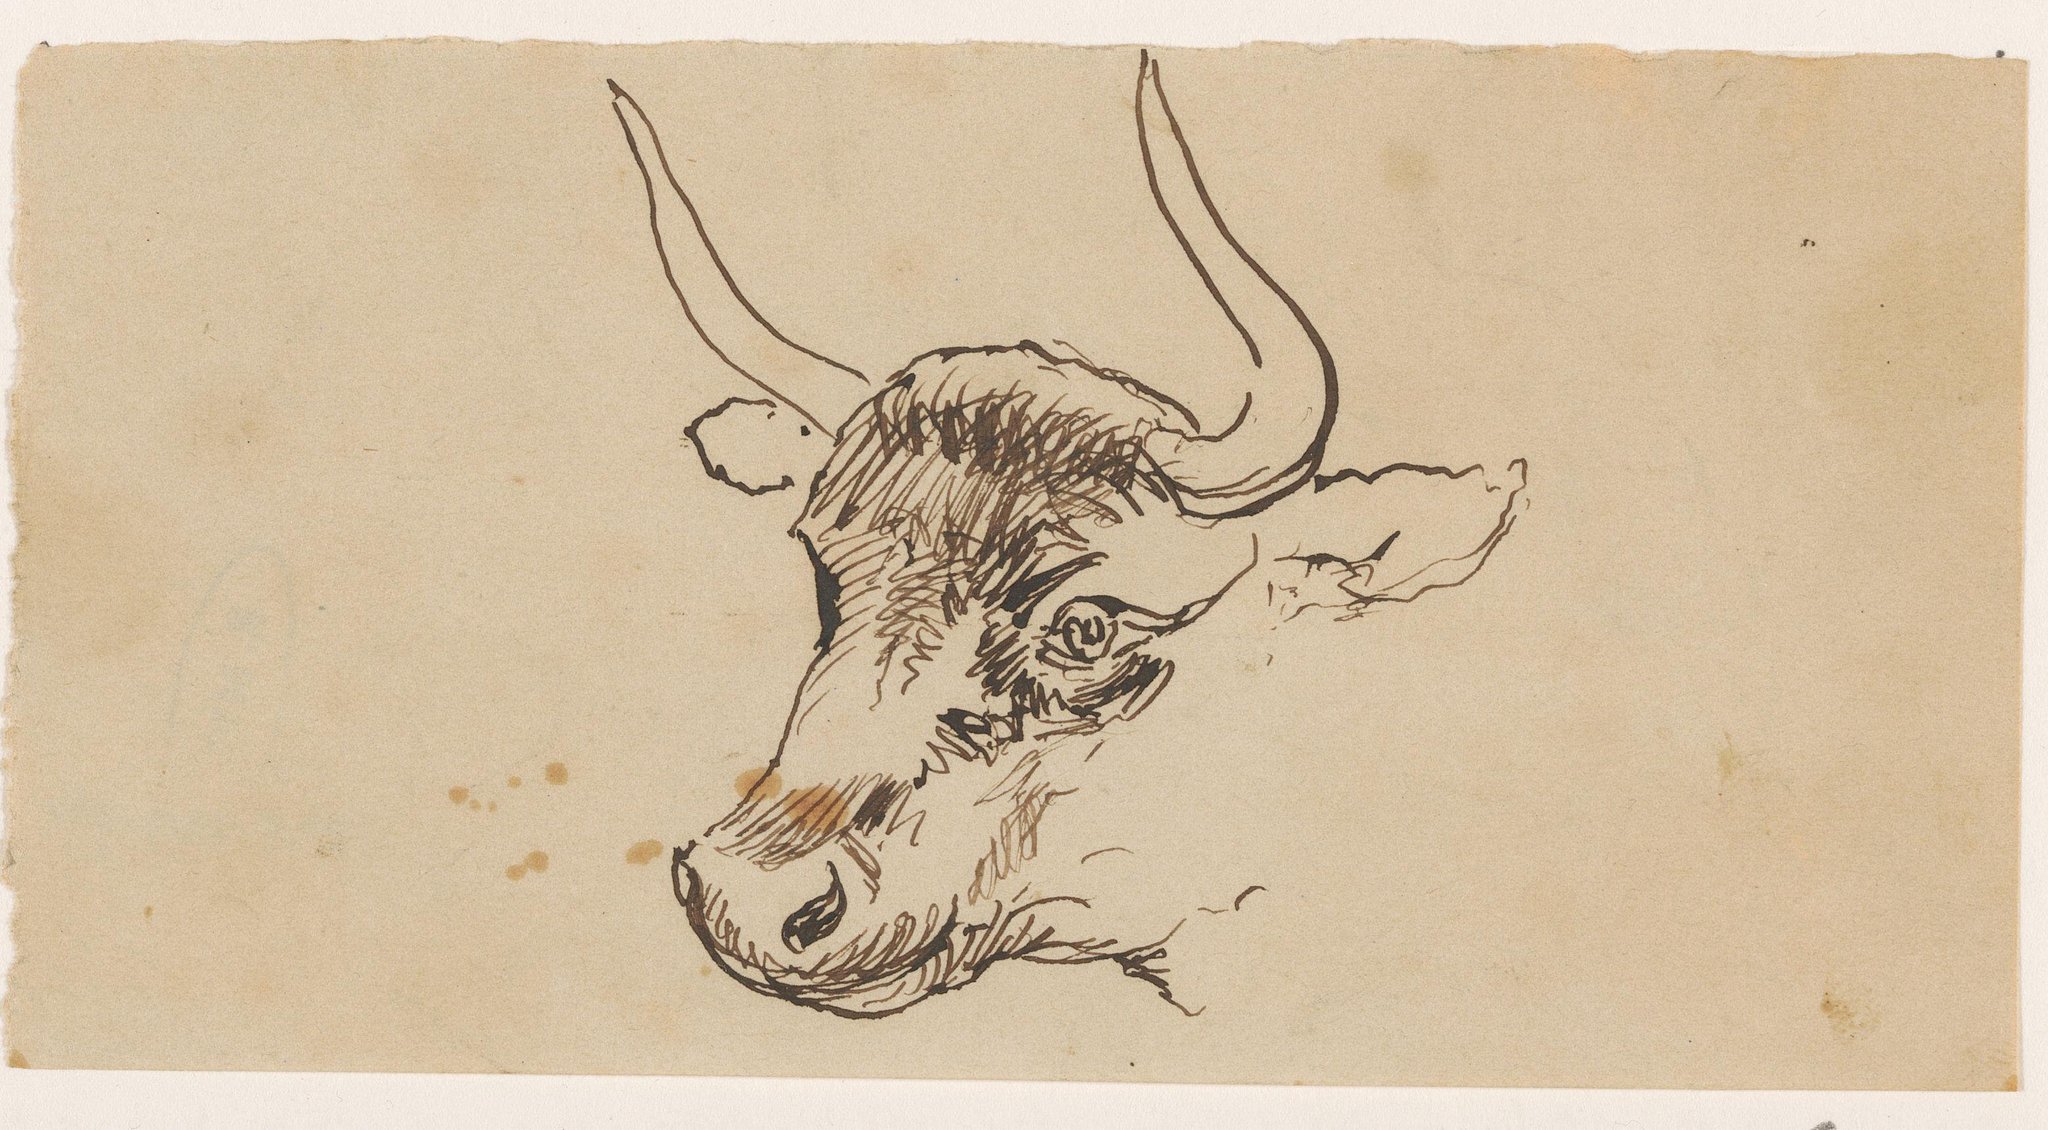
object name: drawing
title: Koeienkop met horens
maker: johannes tavenraat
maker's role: draughtsman, painter, print maker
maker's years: 1809-1881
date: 1840-1880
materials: ink, paper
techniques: pen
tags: cow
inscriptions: collector's mark: Lugt 2228